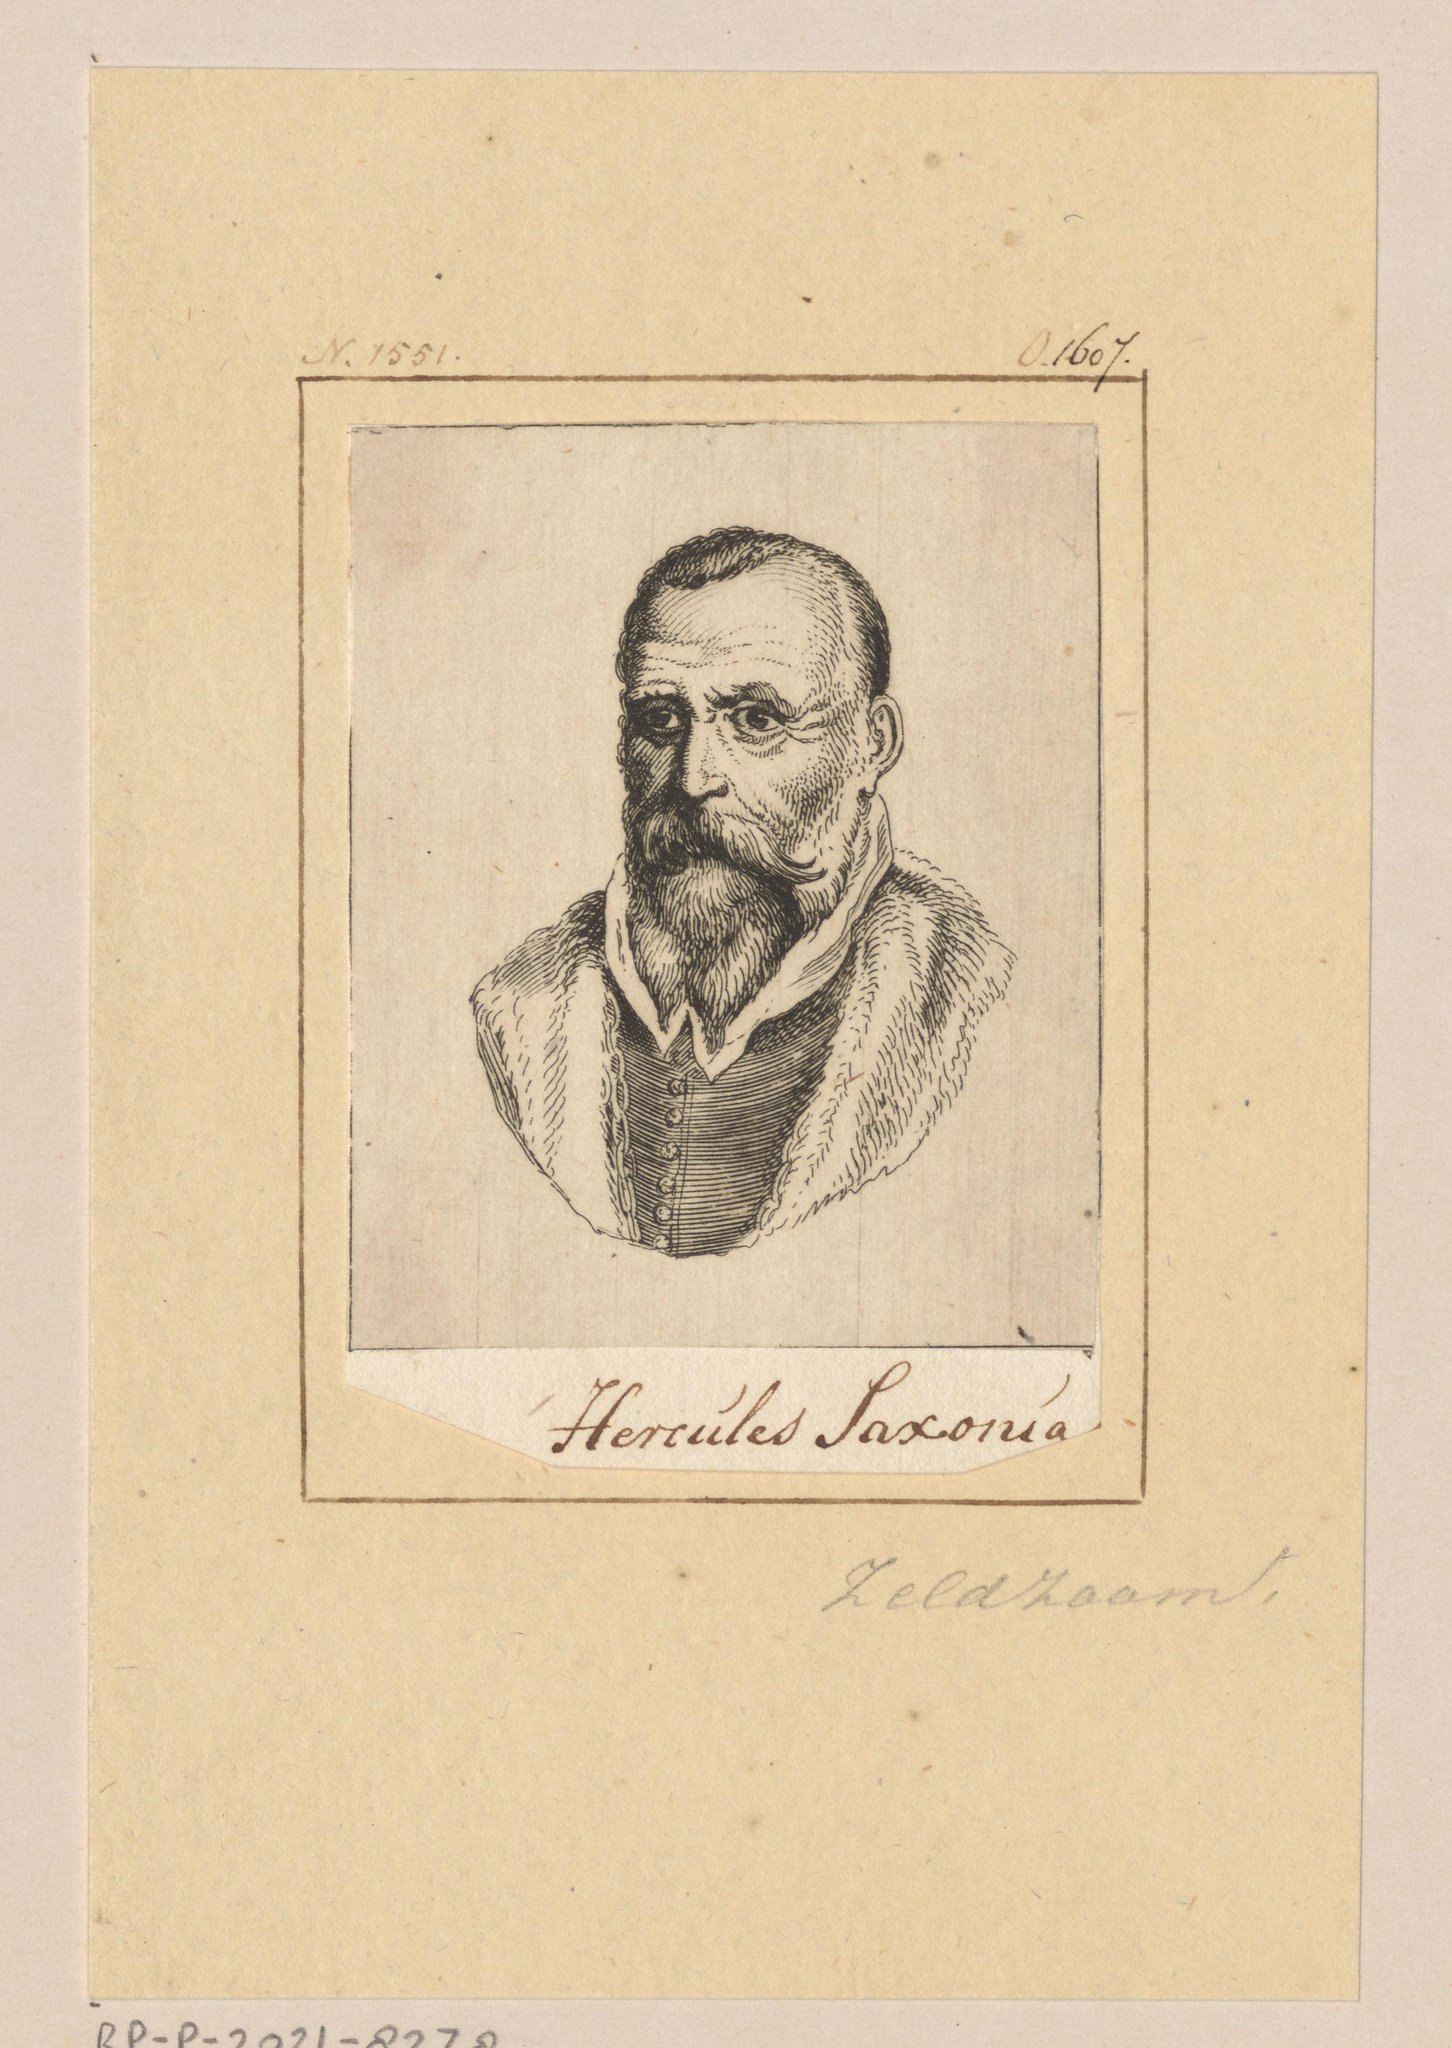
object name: print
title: Portret van Ercole Sassonia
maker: Anonymous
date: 1600-1649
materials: paper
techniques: etching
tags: historical persons, physician, doctor